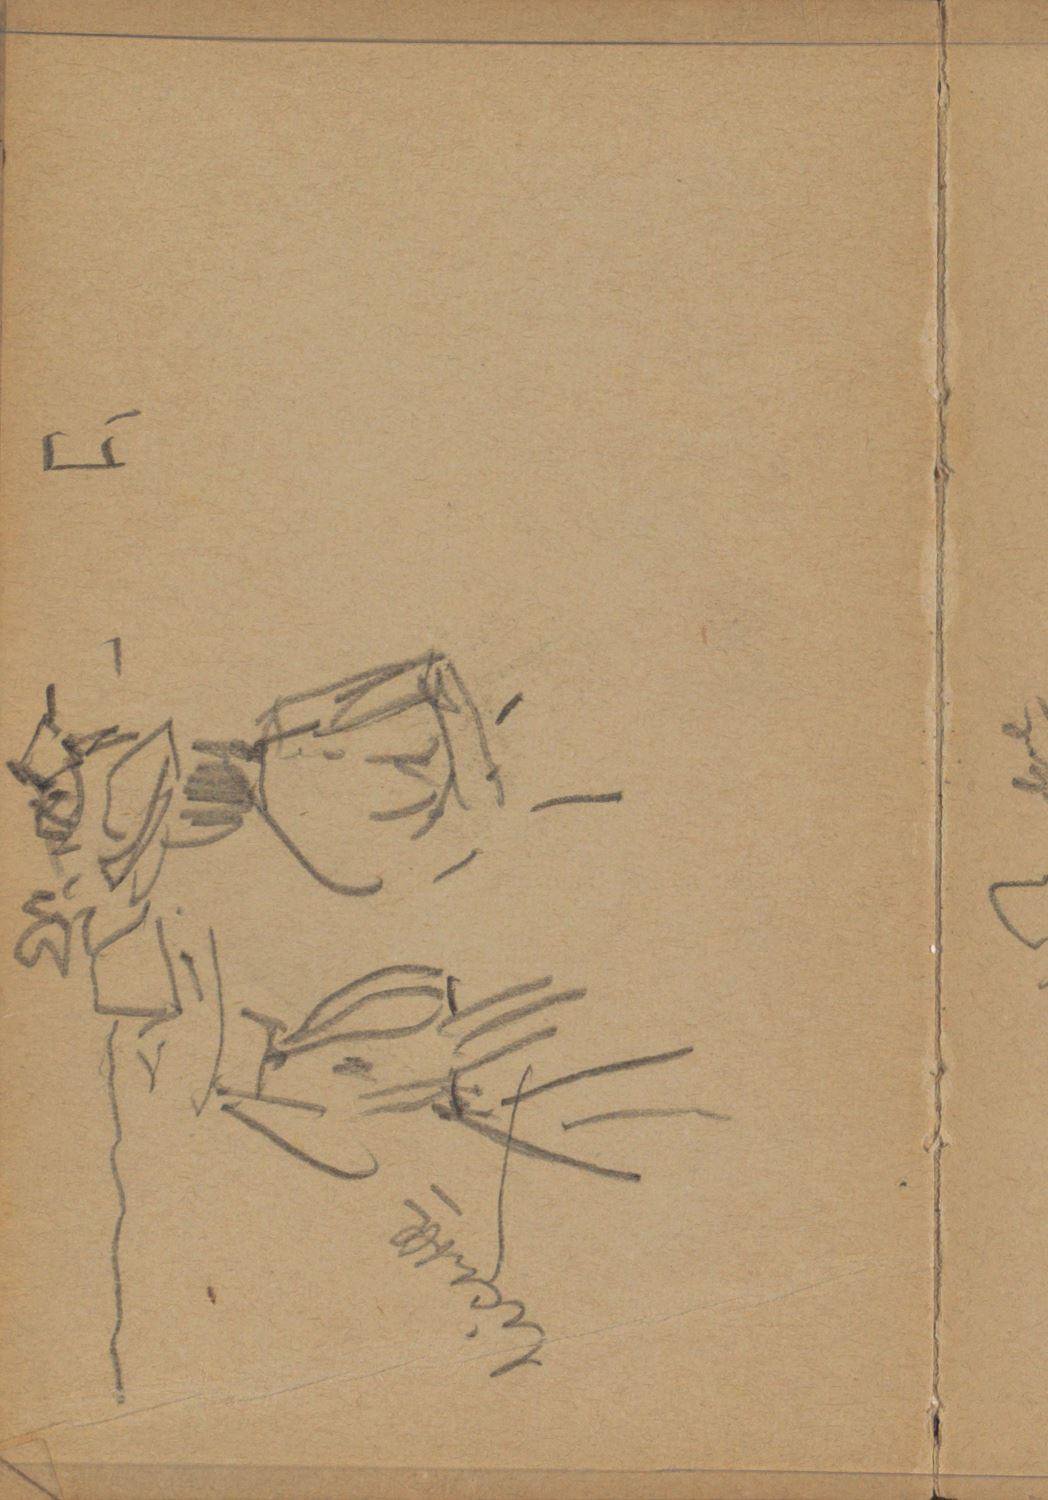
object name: sketchbook leaf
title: Twee vrouwen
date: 1887-1891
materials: paper, pencil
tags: adult woman (+ two persons)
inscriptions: workshop stamp: Lugt 291d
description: Pagina 11 uit een schetsboek met 83 bladen.